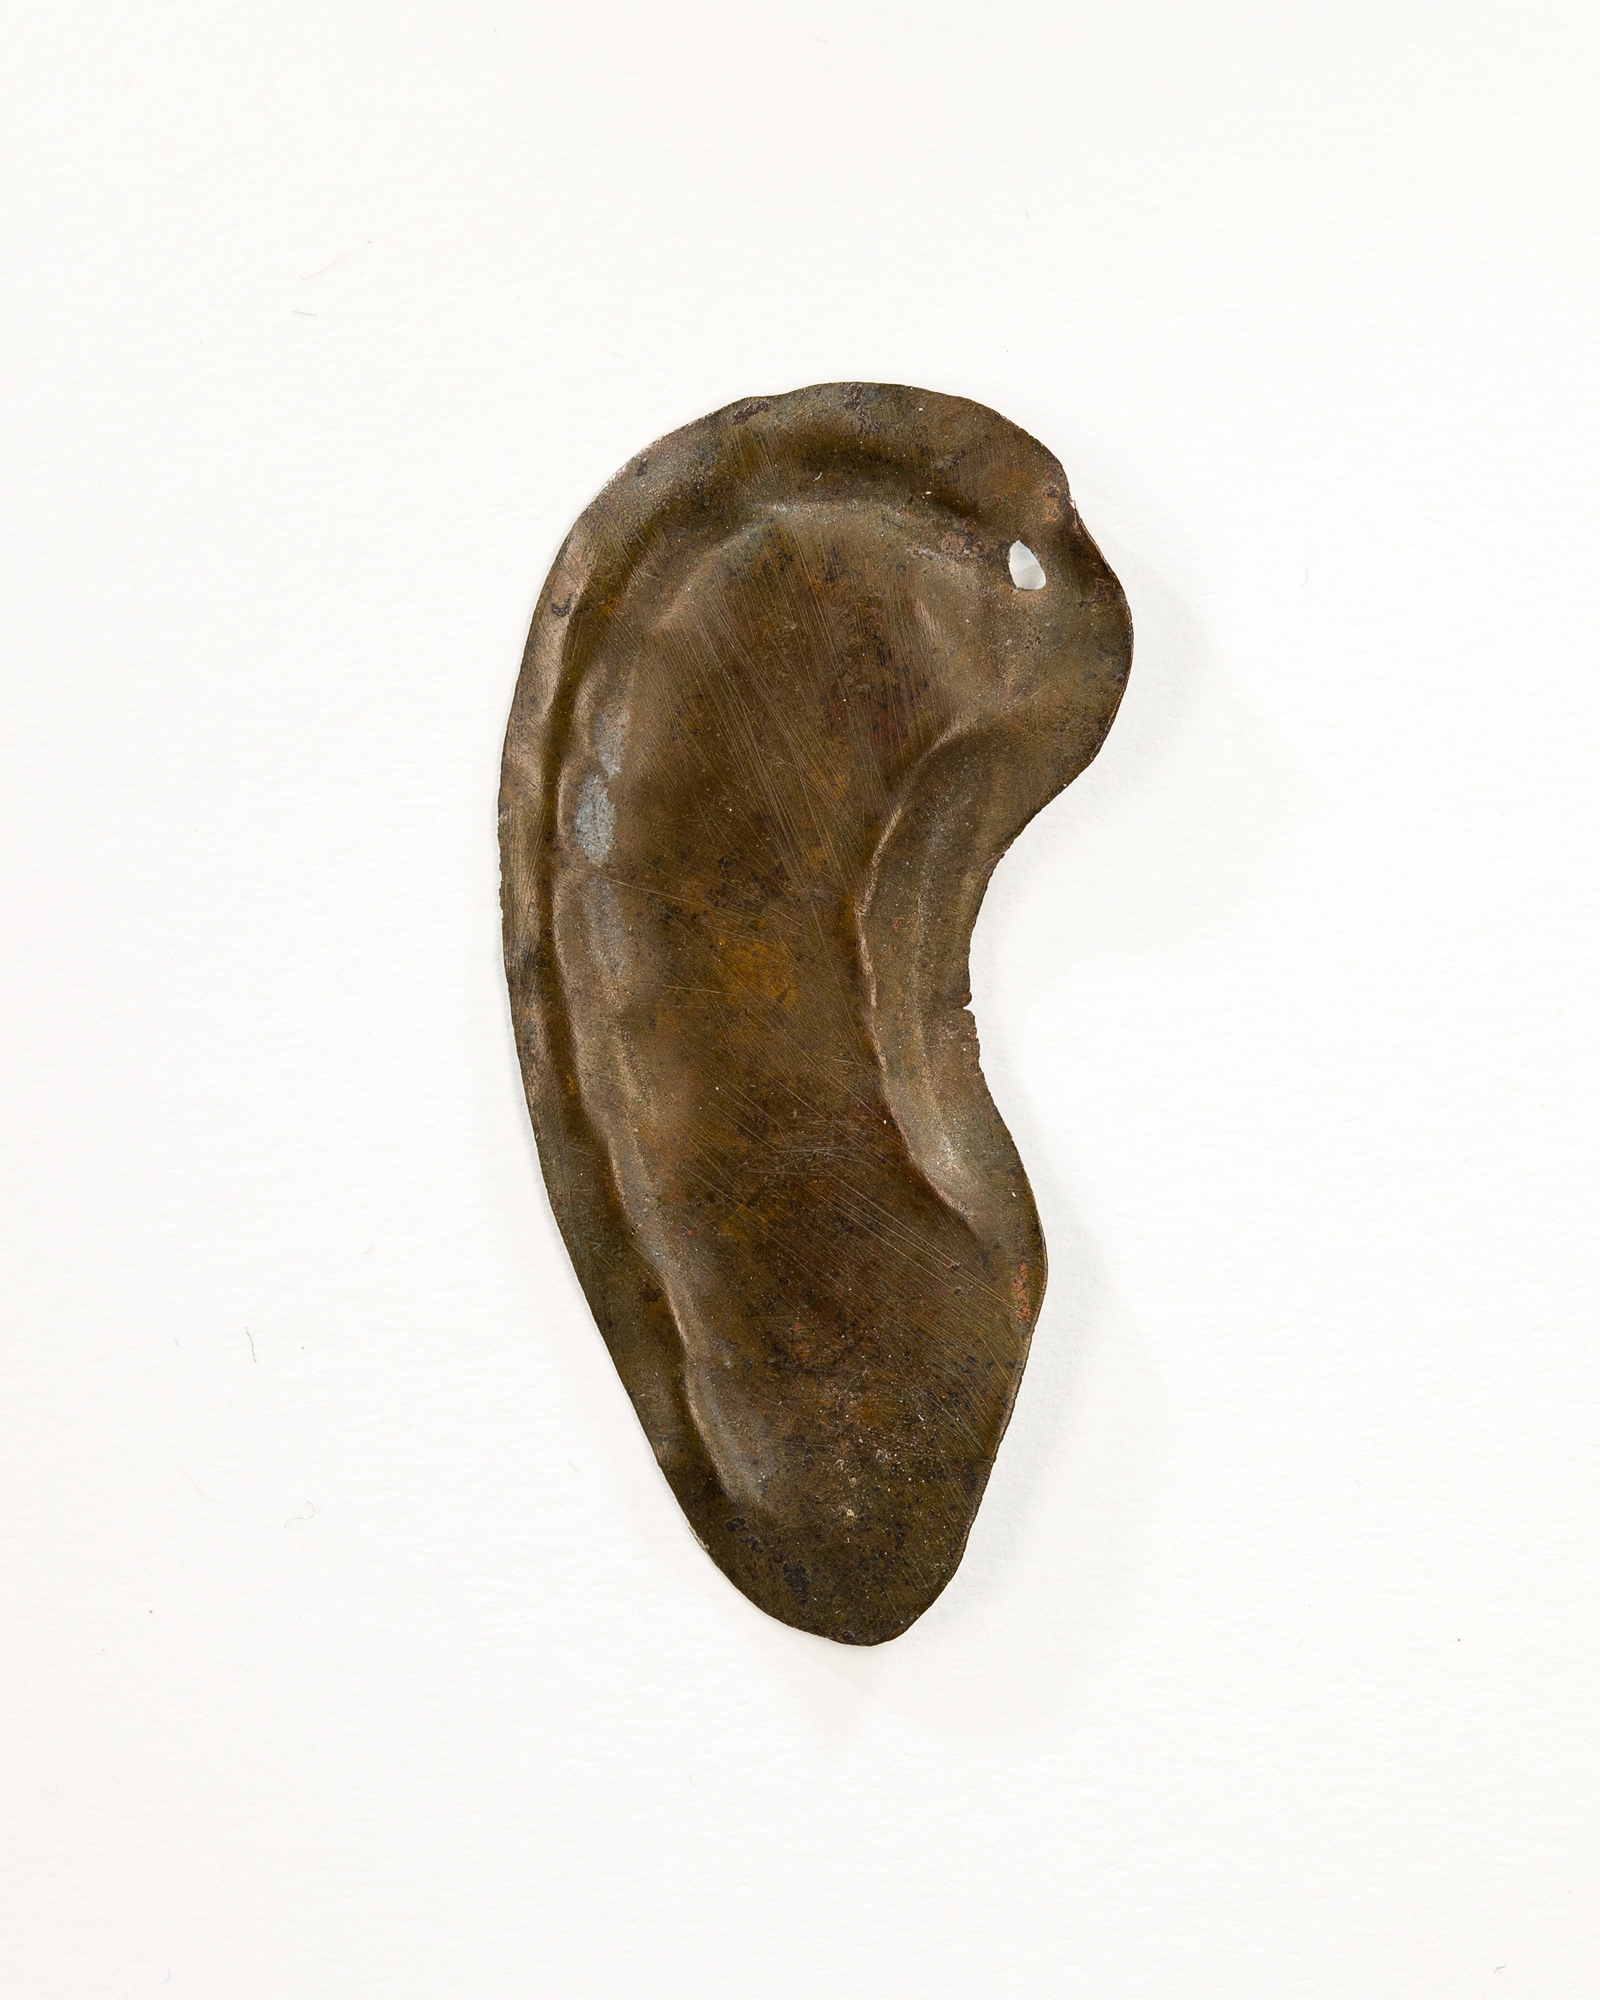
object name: votive, plaque, ear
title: Votive Ear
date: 1479-1458 BCE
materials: bronze, copper alloy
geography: egypt